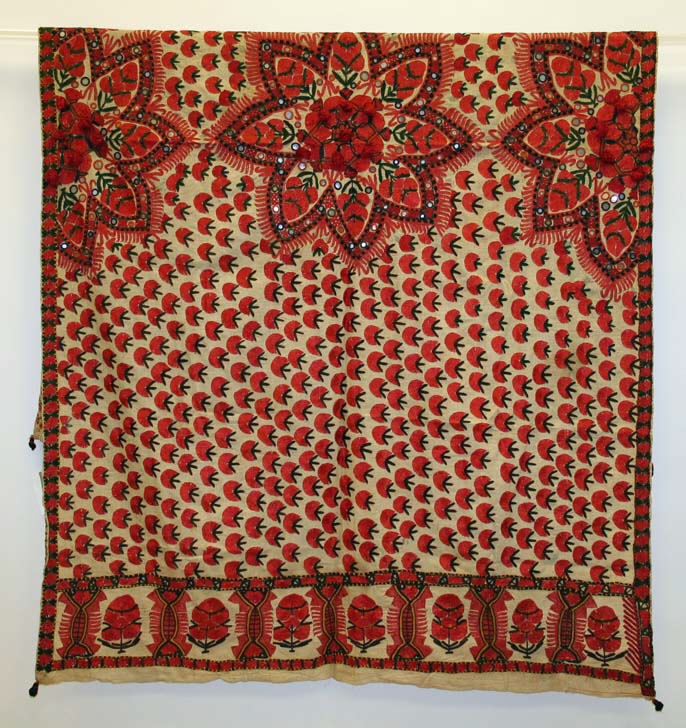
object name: wedding shawl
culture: indian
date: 1801-1900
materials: silk